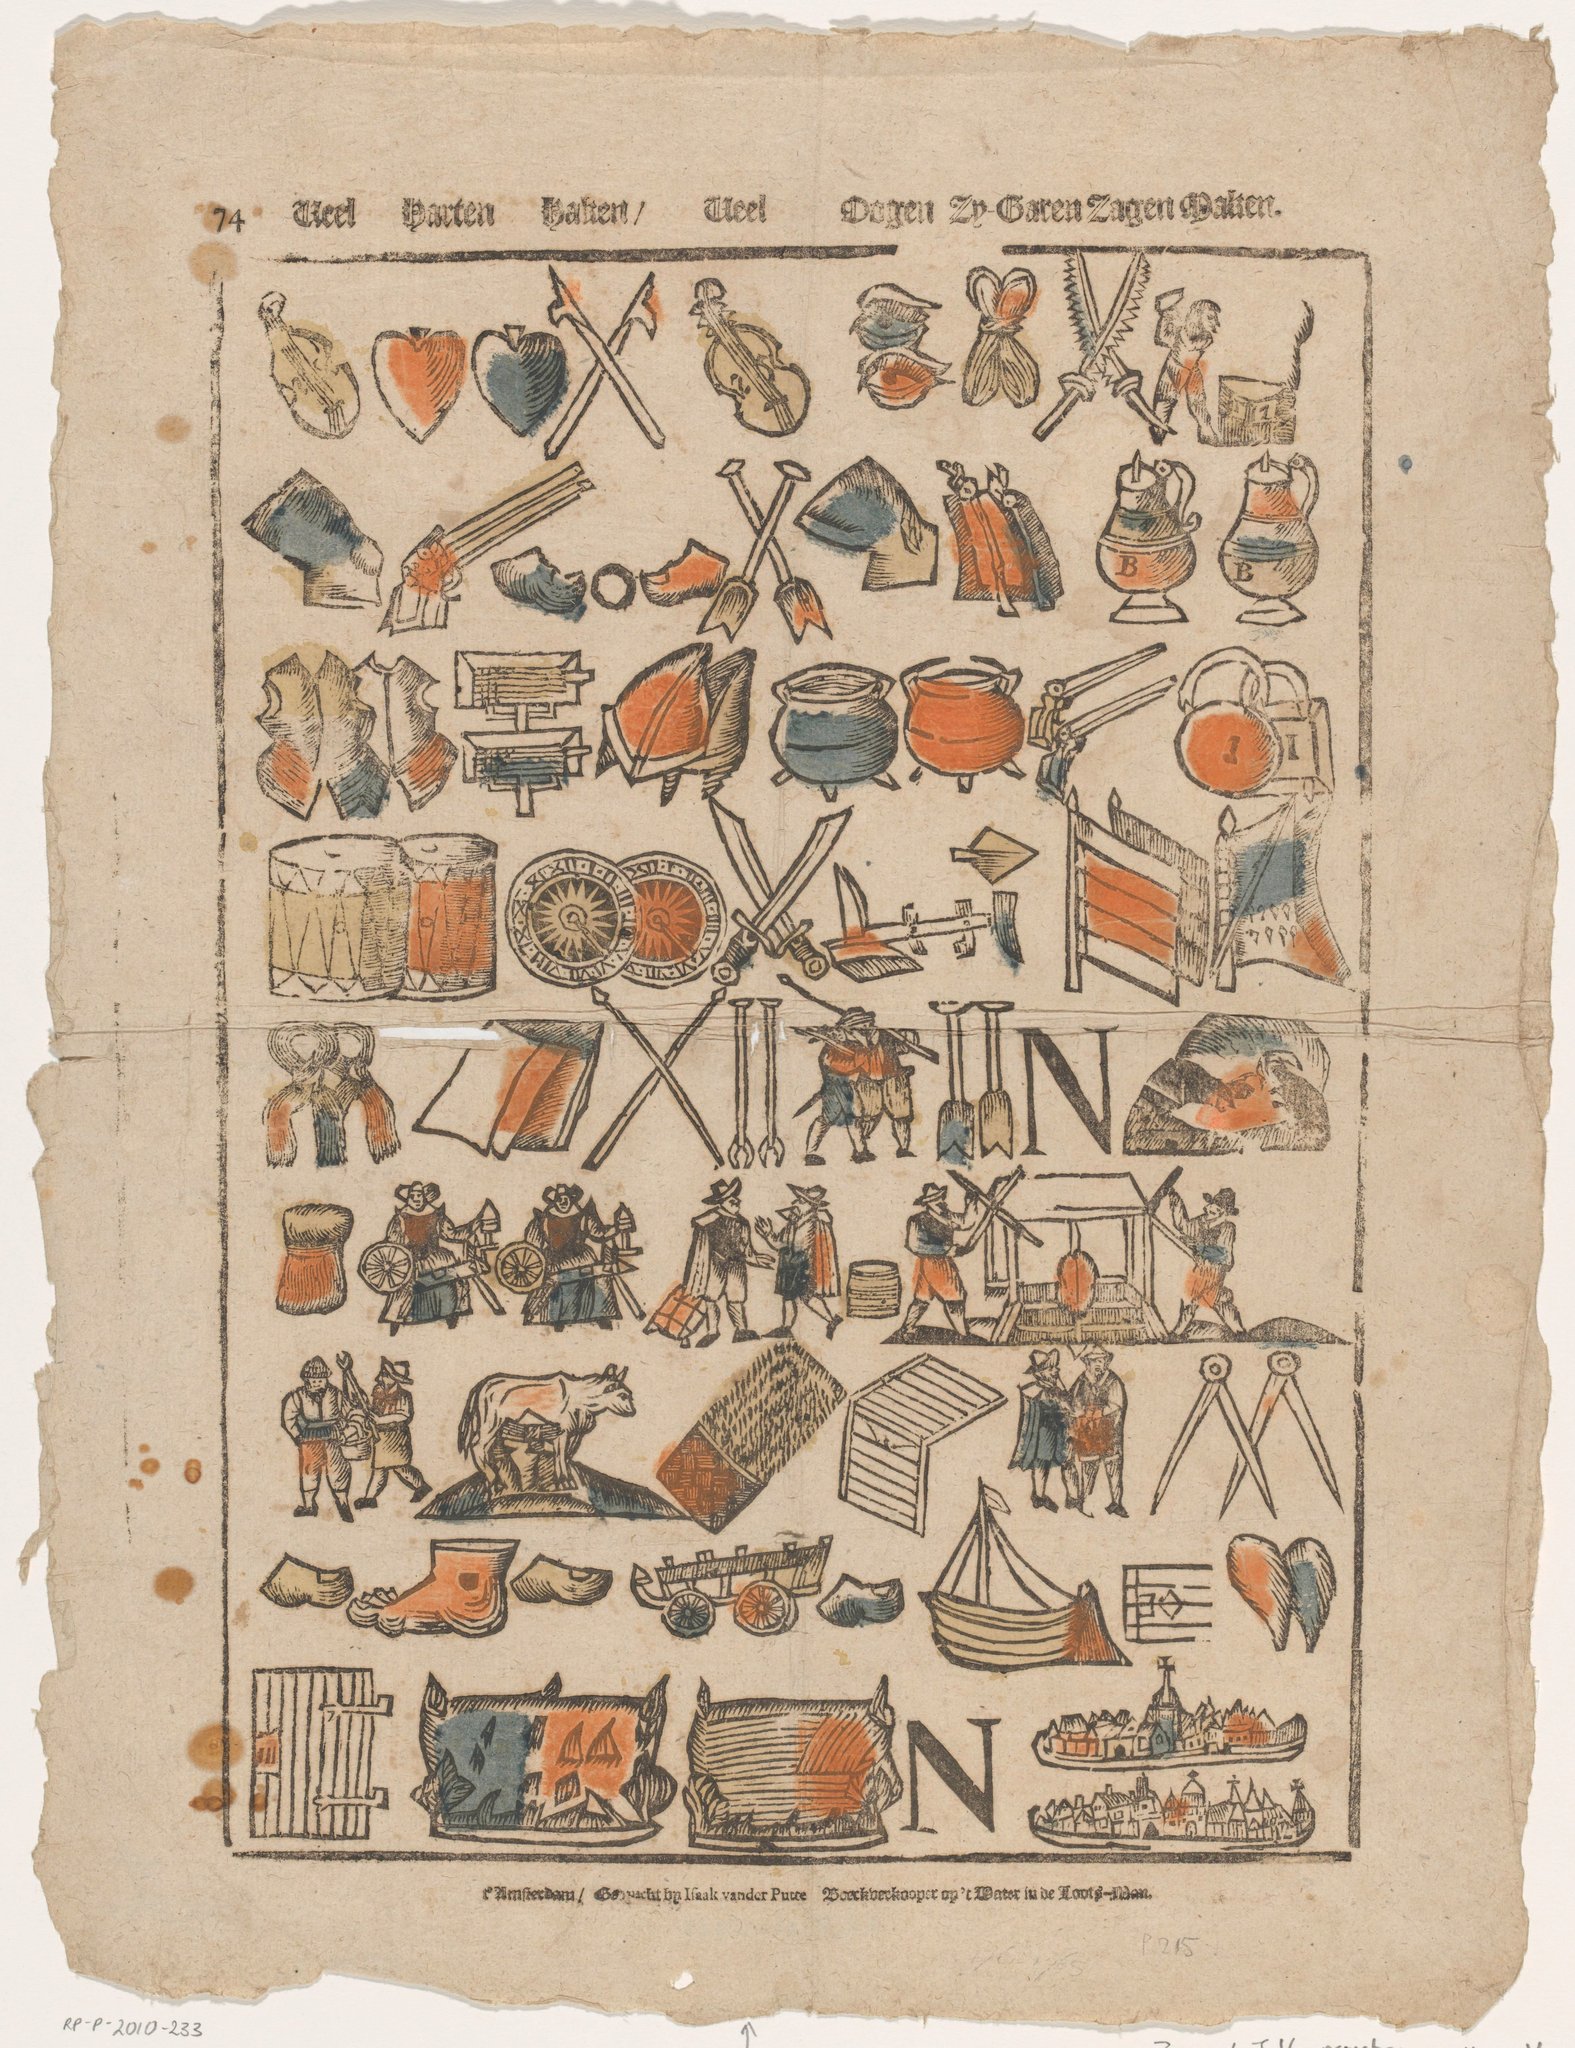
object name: print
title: Veel harten haken / Veel oogen zy-garen zagen maken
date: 1723-1748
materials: paper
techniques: colour, letterpress printing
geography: netherlands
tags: rebus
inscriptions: collector's mark: Lugt 2228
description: Blad met een rebus bestaande uit negen rijen met voorstellingen. Genummerd linksboven: 74.